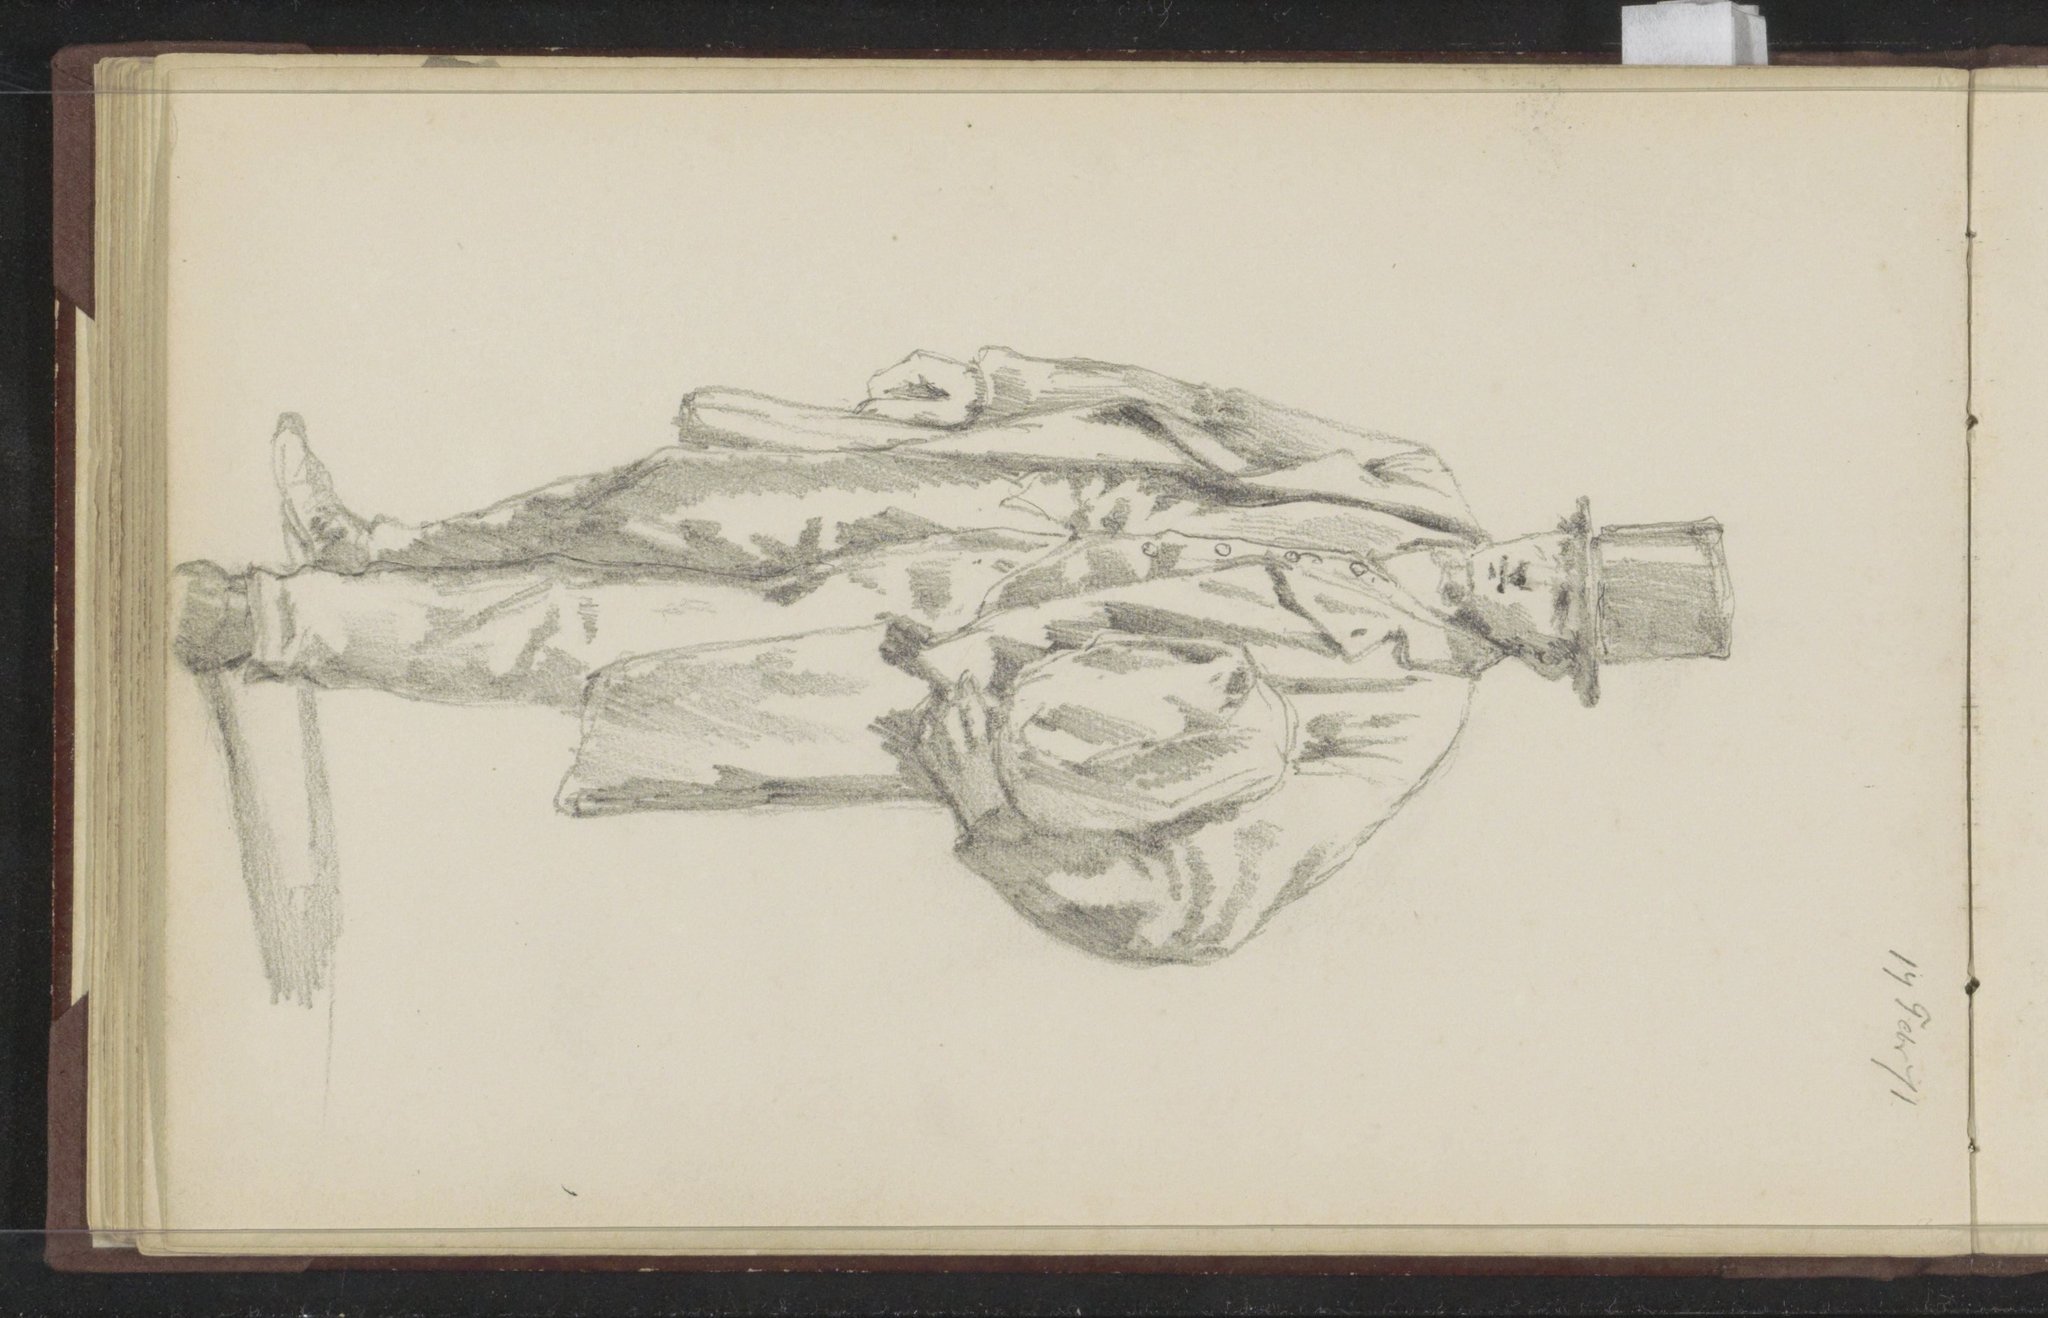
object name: sketchbook leaf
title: Man met een hoge hoed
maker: cornelis springer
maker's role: draughtsman, painter, print maker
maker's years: 1817-1891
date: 1871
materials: paper, pencil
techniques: stumping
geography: netherlands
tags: adult man, head-gear: top hat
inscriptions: date: ‘17 Febr 71’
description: Man met een hoge hoed. Onder zijn arm draagt hij spullen. Blad 18 verso uit een schetsboek met 39 bladen, deels vervaardigd te Ulm en Leiden.